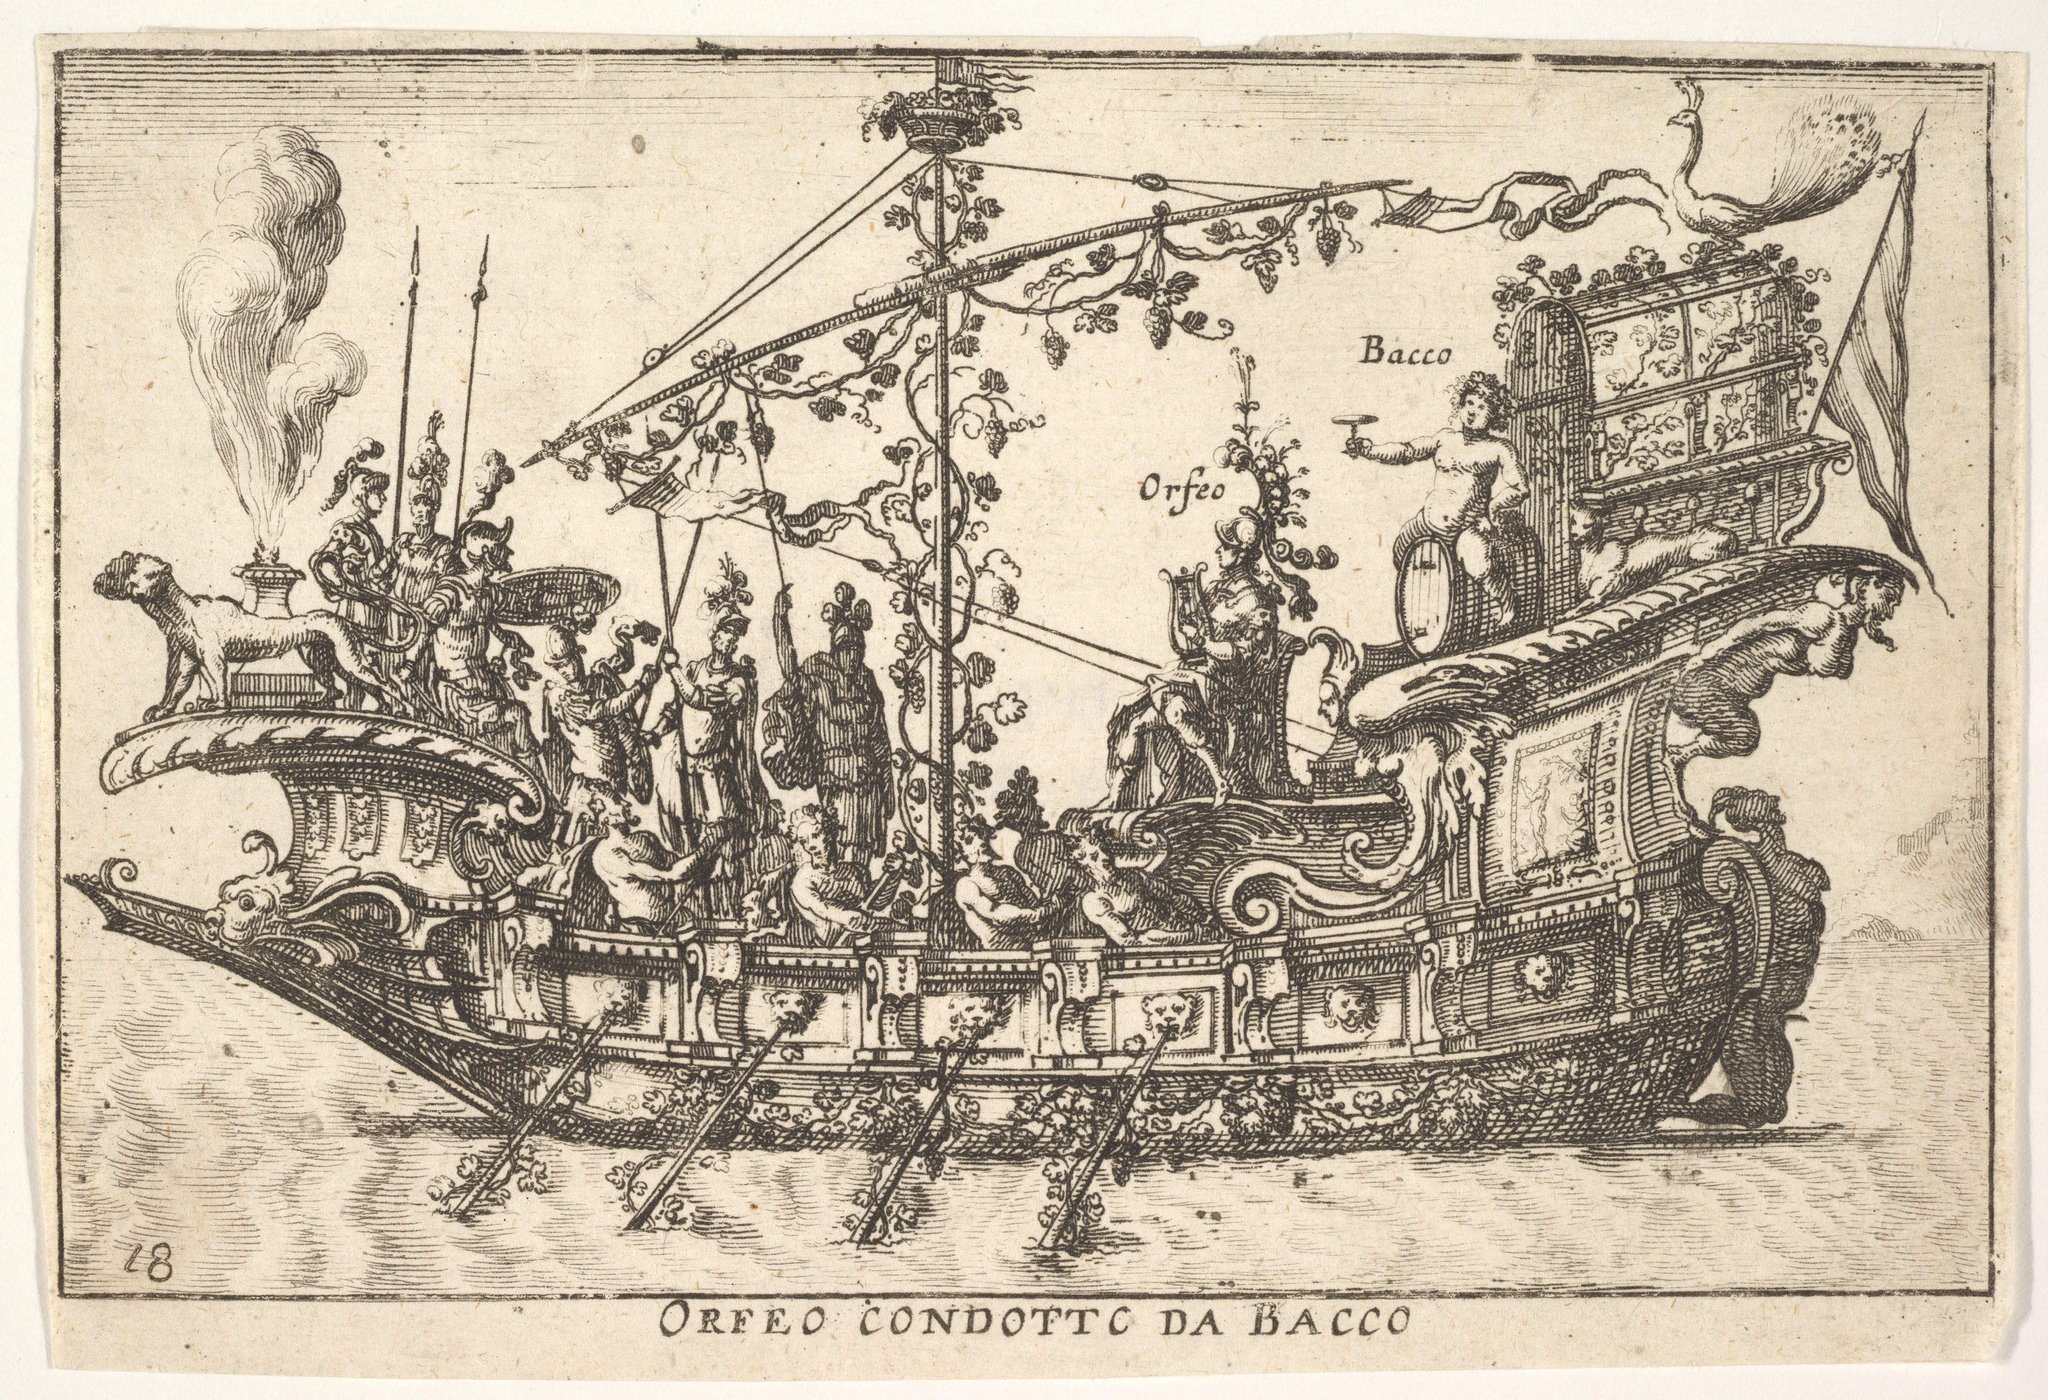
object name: print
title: Plate 18: Orpheus led by Bacchus (Orfeo condotto da Bacco), from "The magnificent pageant on the river Arno in Florence for the marriage of the Grand Duke" (Le Magnifique carousel fait sur le fleuve de l'Arne a Florence, pour le mariage du Grand Duc)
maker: Anonymous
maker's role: artist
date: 1664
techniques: etching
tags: orpheus,bacchus,ships